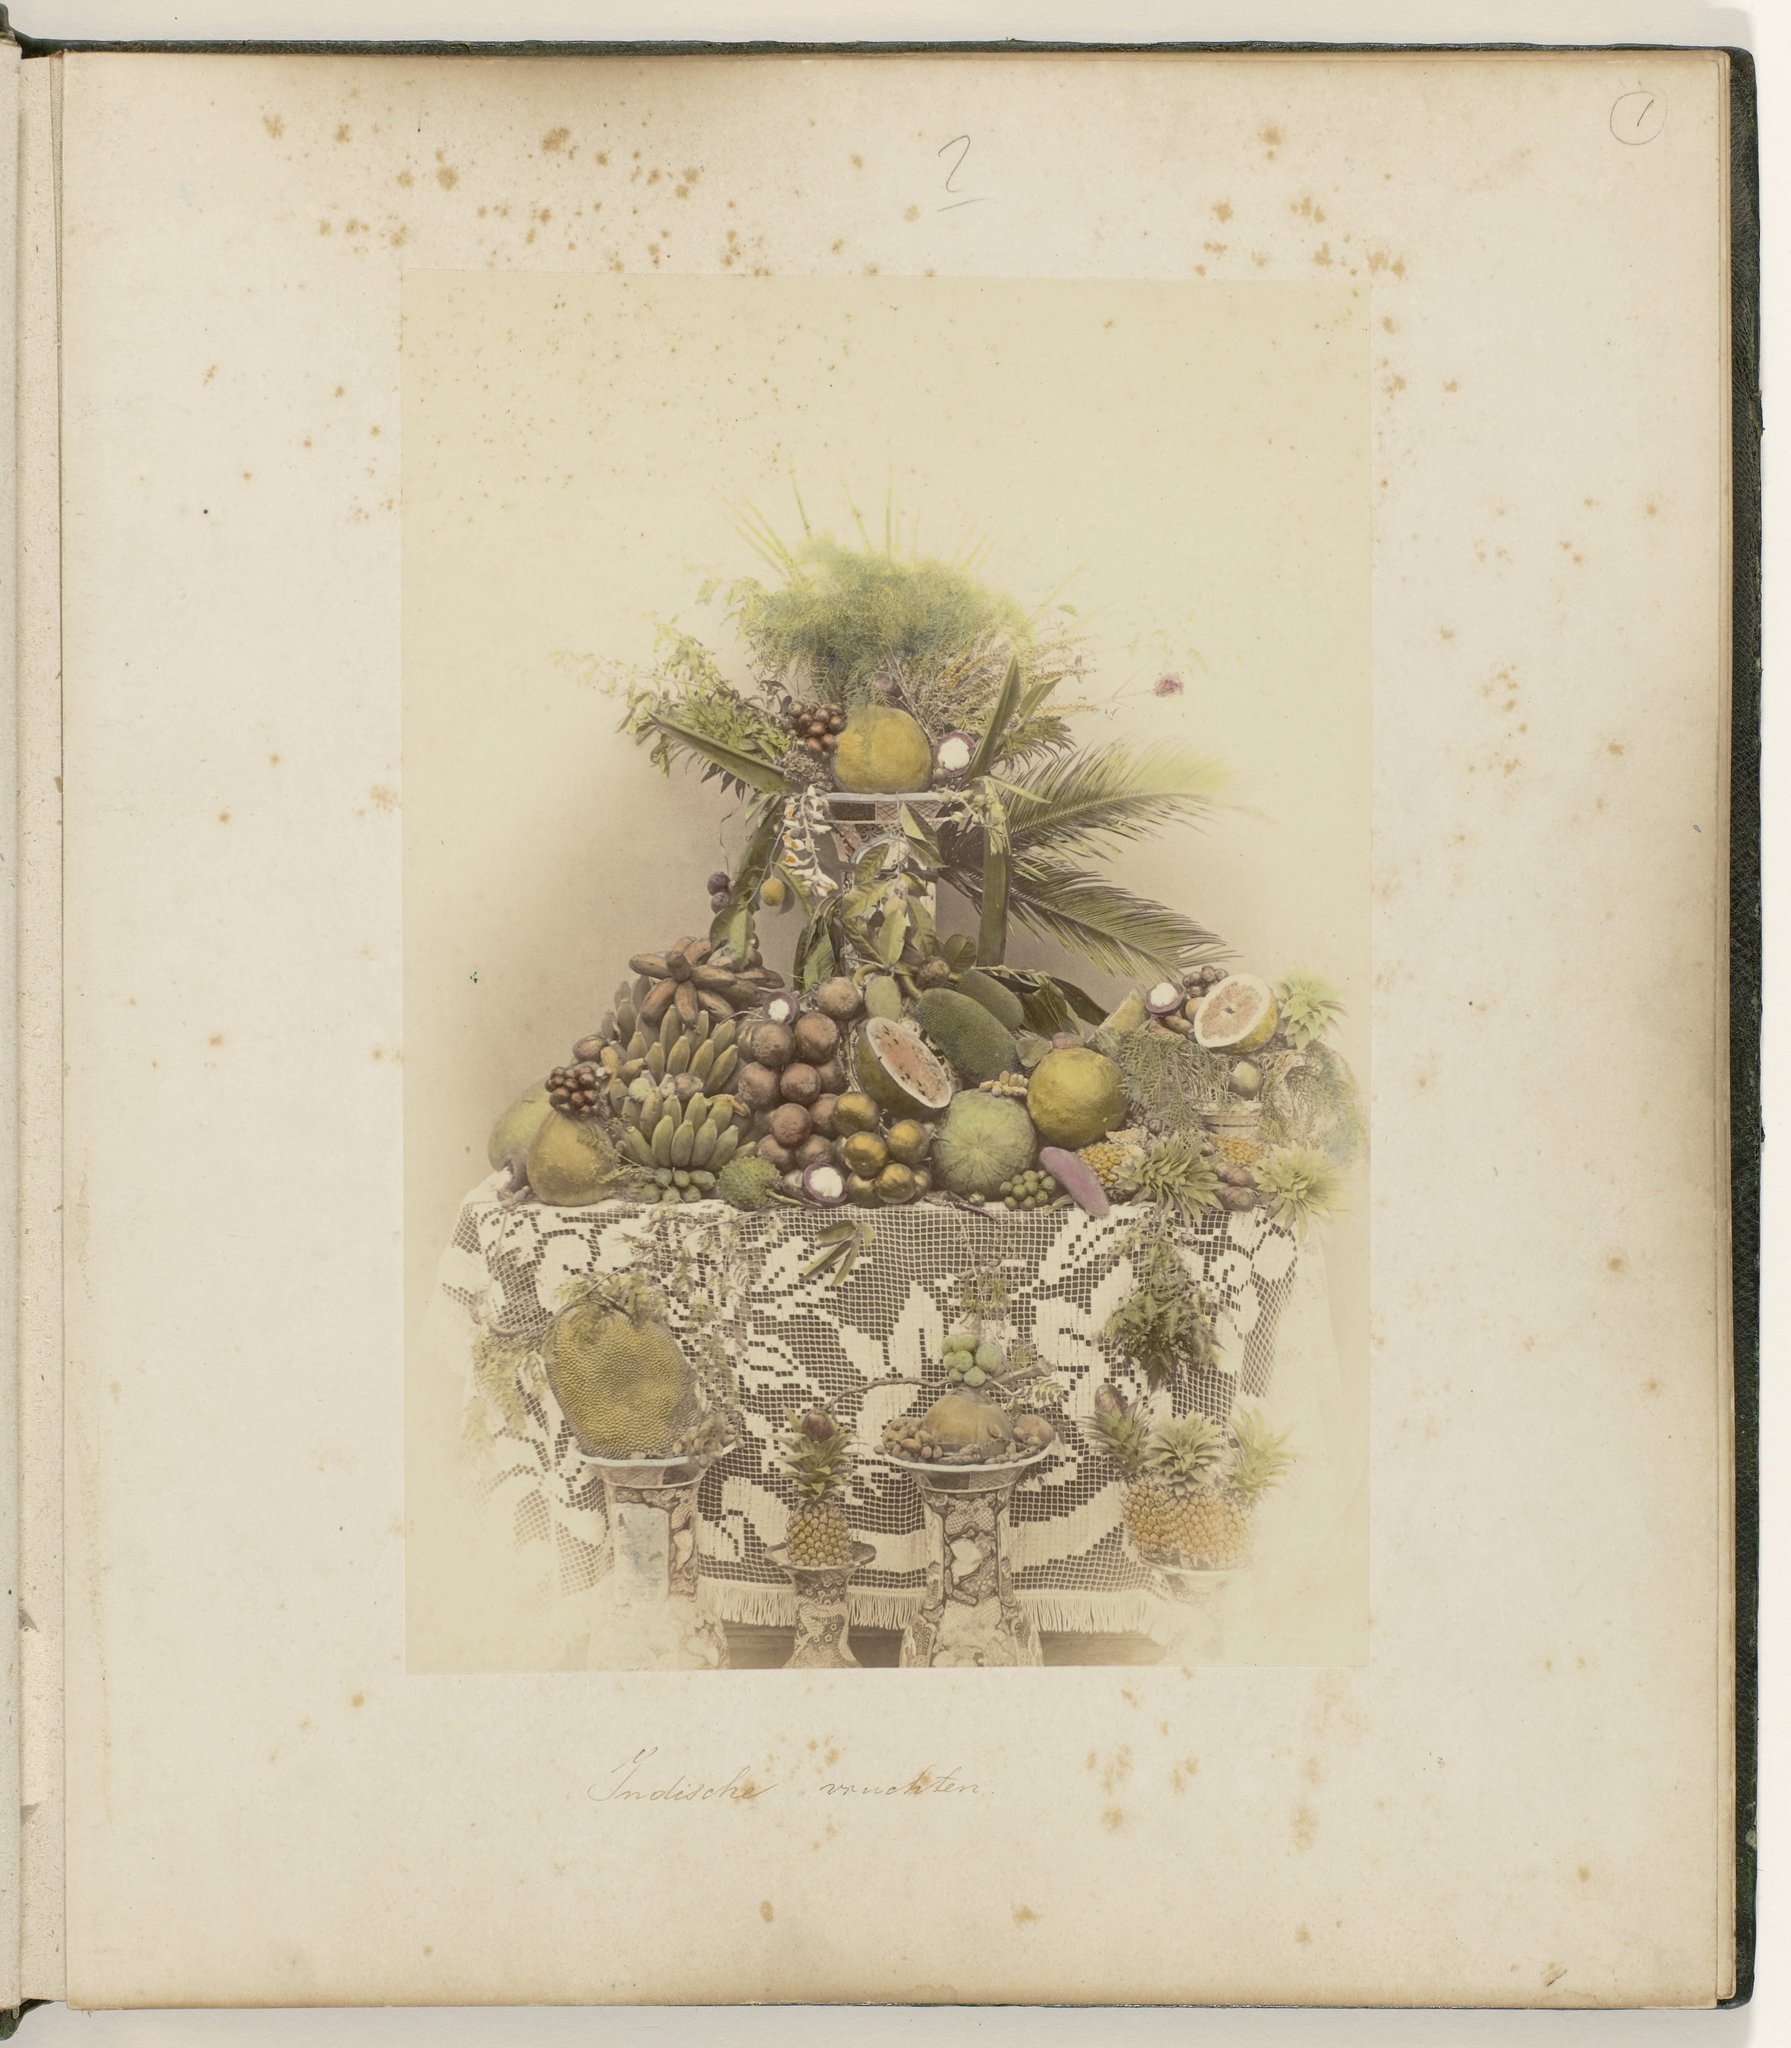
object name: photograph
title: Indonesische vruchten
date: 1863-1866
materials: photographic support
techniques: albumen print, hand coloring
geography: batavia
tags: fruits, java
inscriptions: inscription: ‘Indische vruchten’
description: Stilleven met Indonesische vruchten opgesteld op een tafel. Onderdeel van het tweede groene fotoalbum met foto's van Java, uit het bezit van apotheker Specht-Grijp, die in 1865 vanuit Batavia naar Nederland terugkeerde.